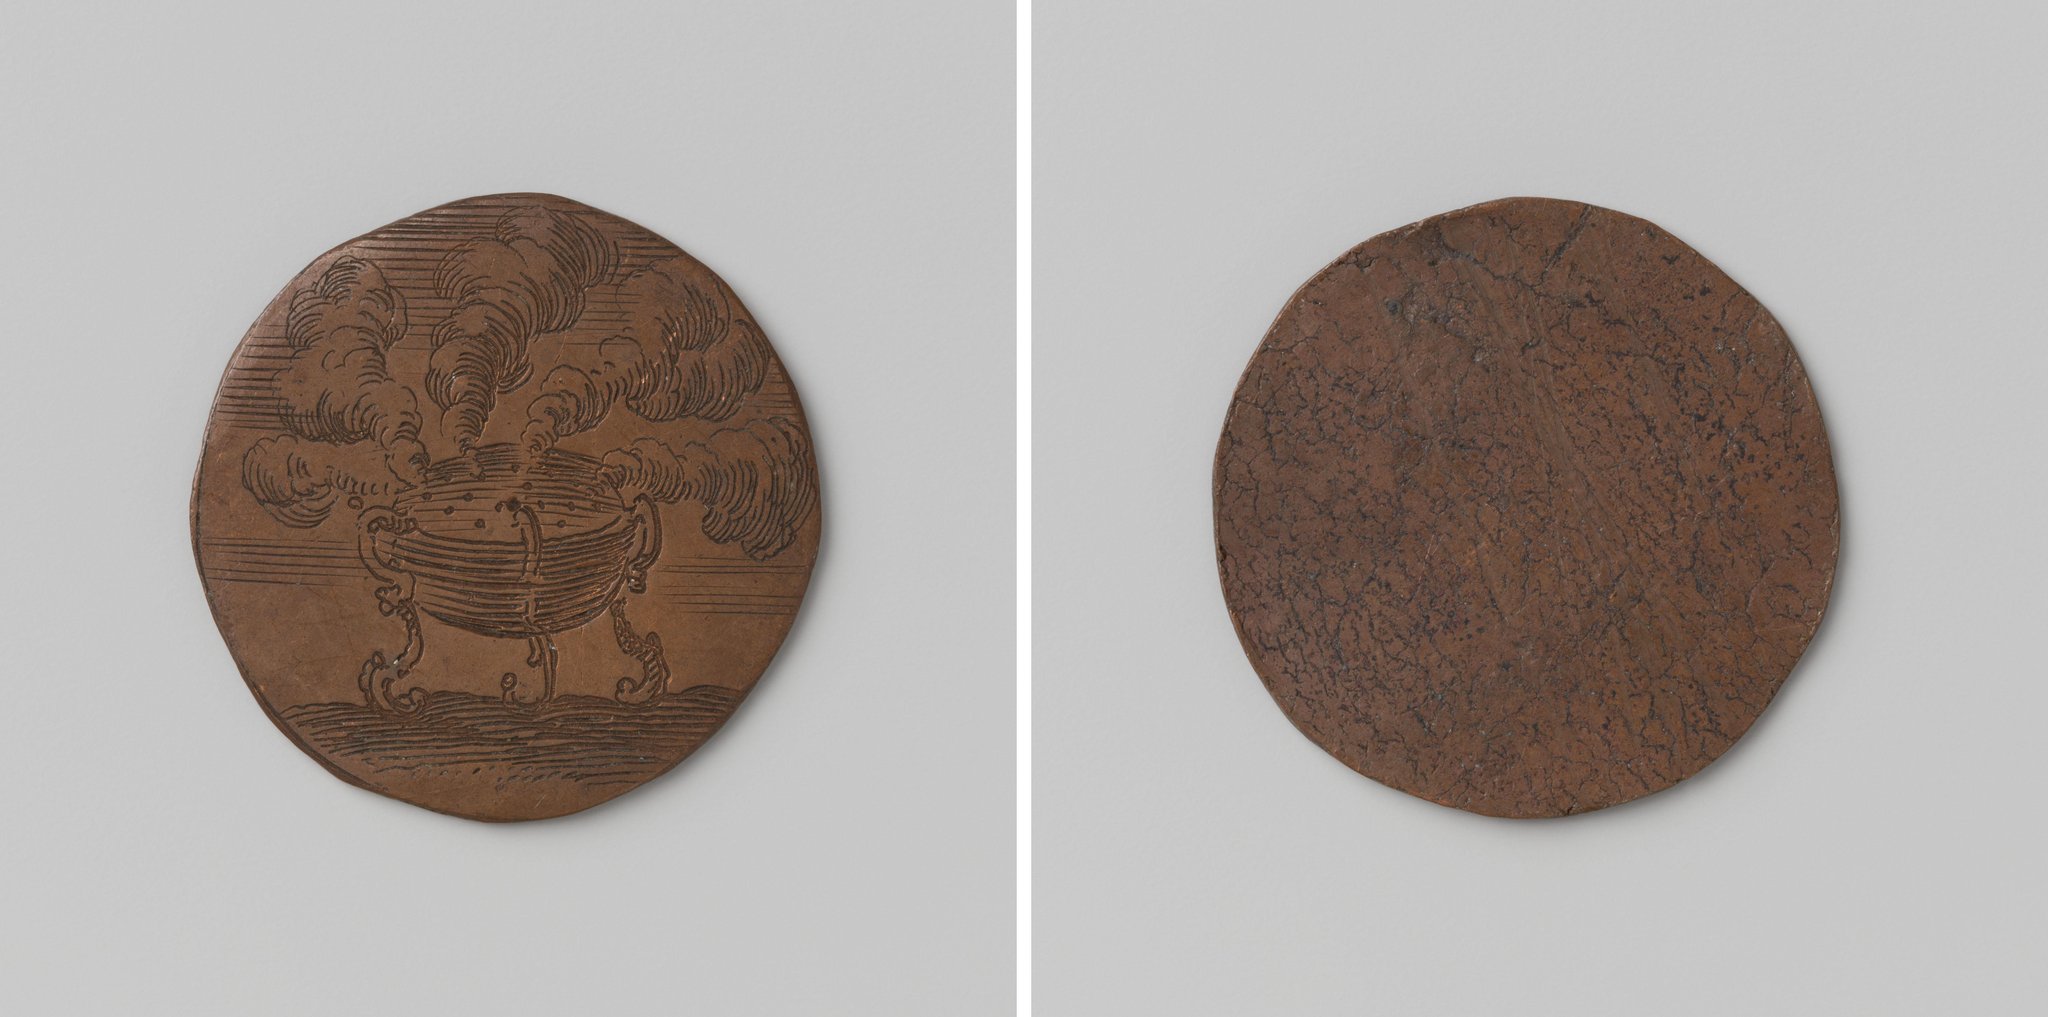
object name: medal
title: Kookpot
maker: Anonymous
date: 1600-1700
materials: copper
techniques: engraving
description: Eenzijdig gegraveerde koperen penning. Voorzijde: grote rokende pot. Keerzijde: blanco.